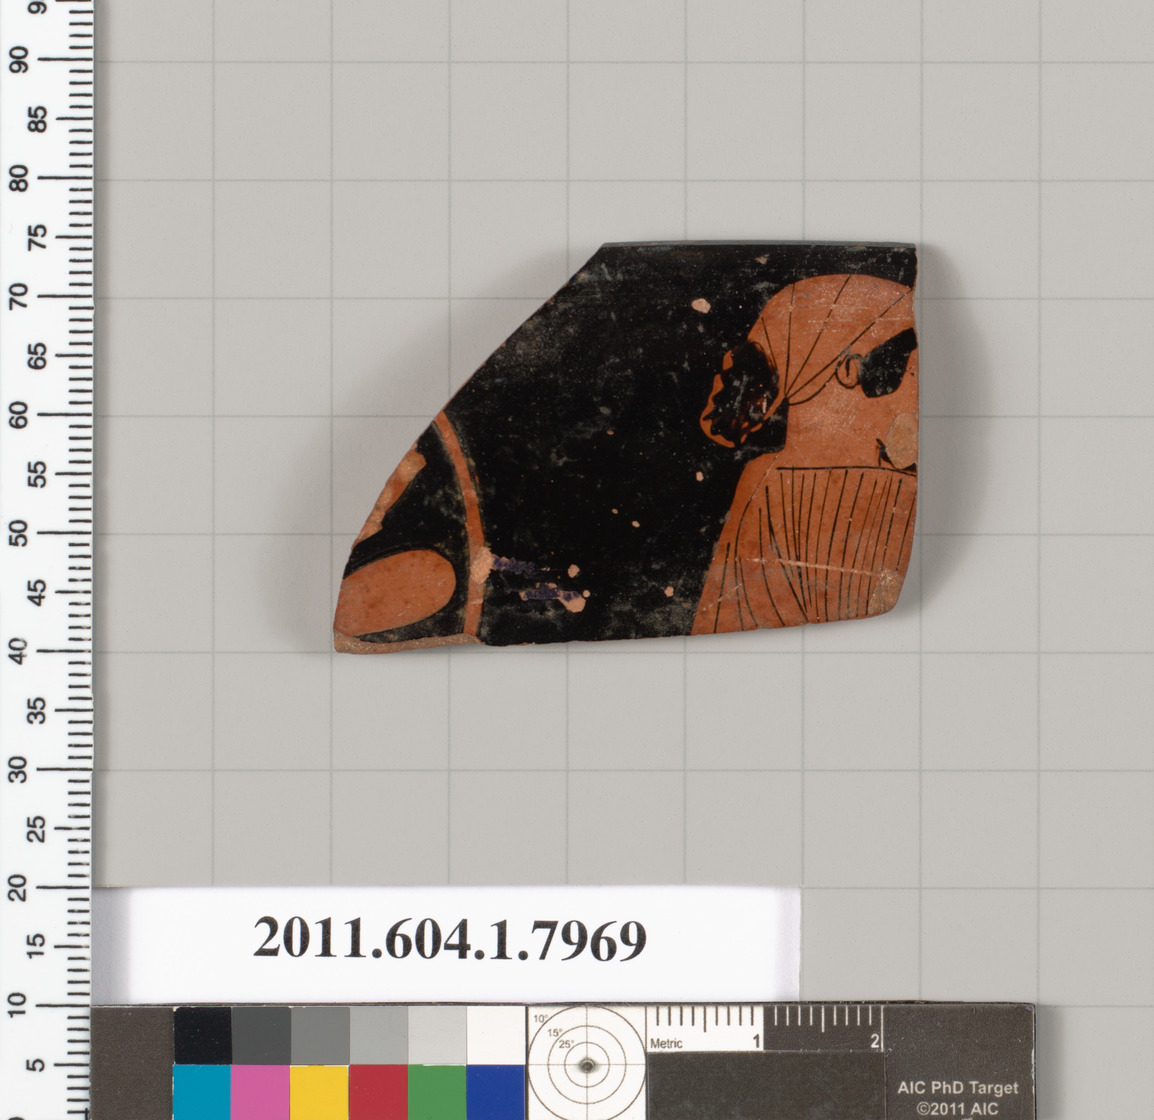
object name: kylix fragment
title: Terracotta rim fragment of a kylix (drinking cup)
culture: greek, attic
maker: sabouroff painter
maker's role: artist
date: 450 BCE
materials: terracotta